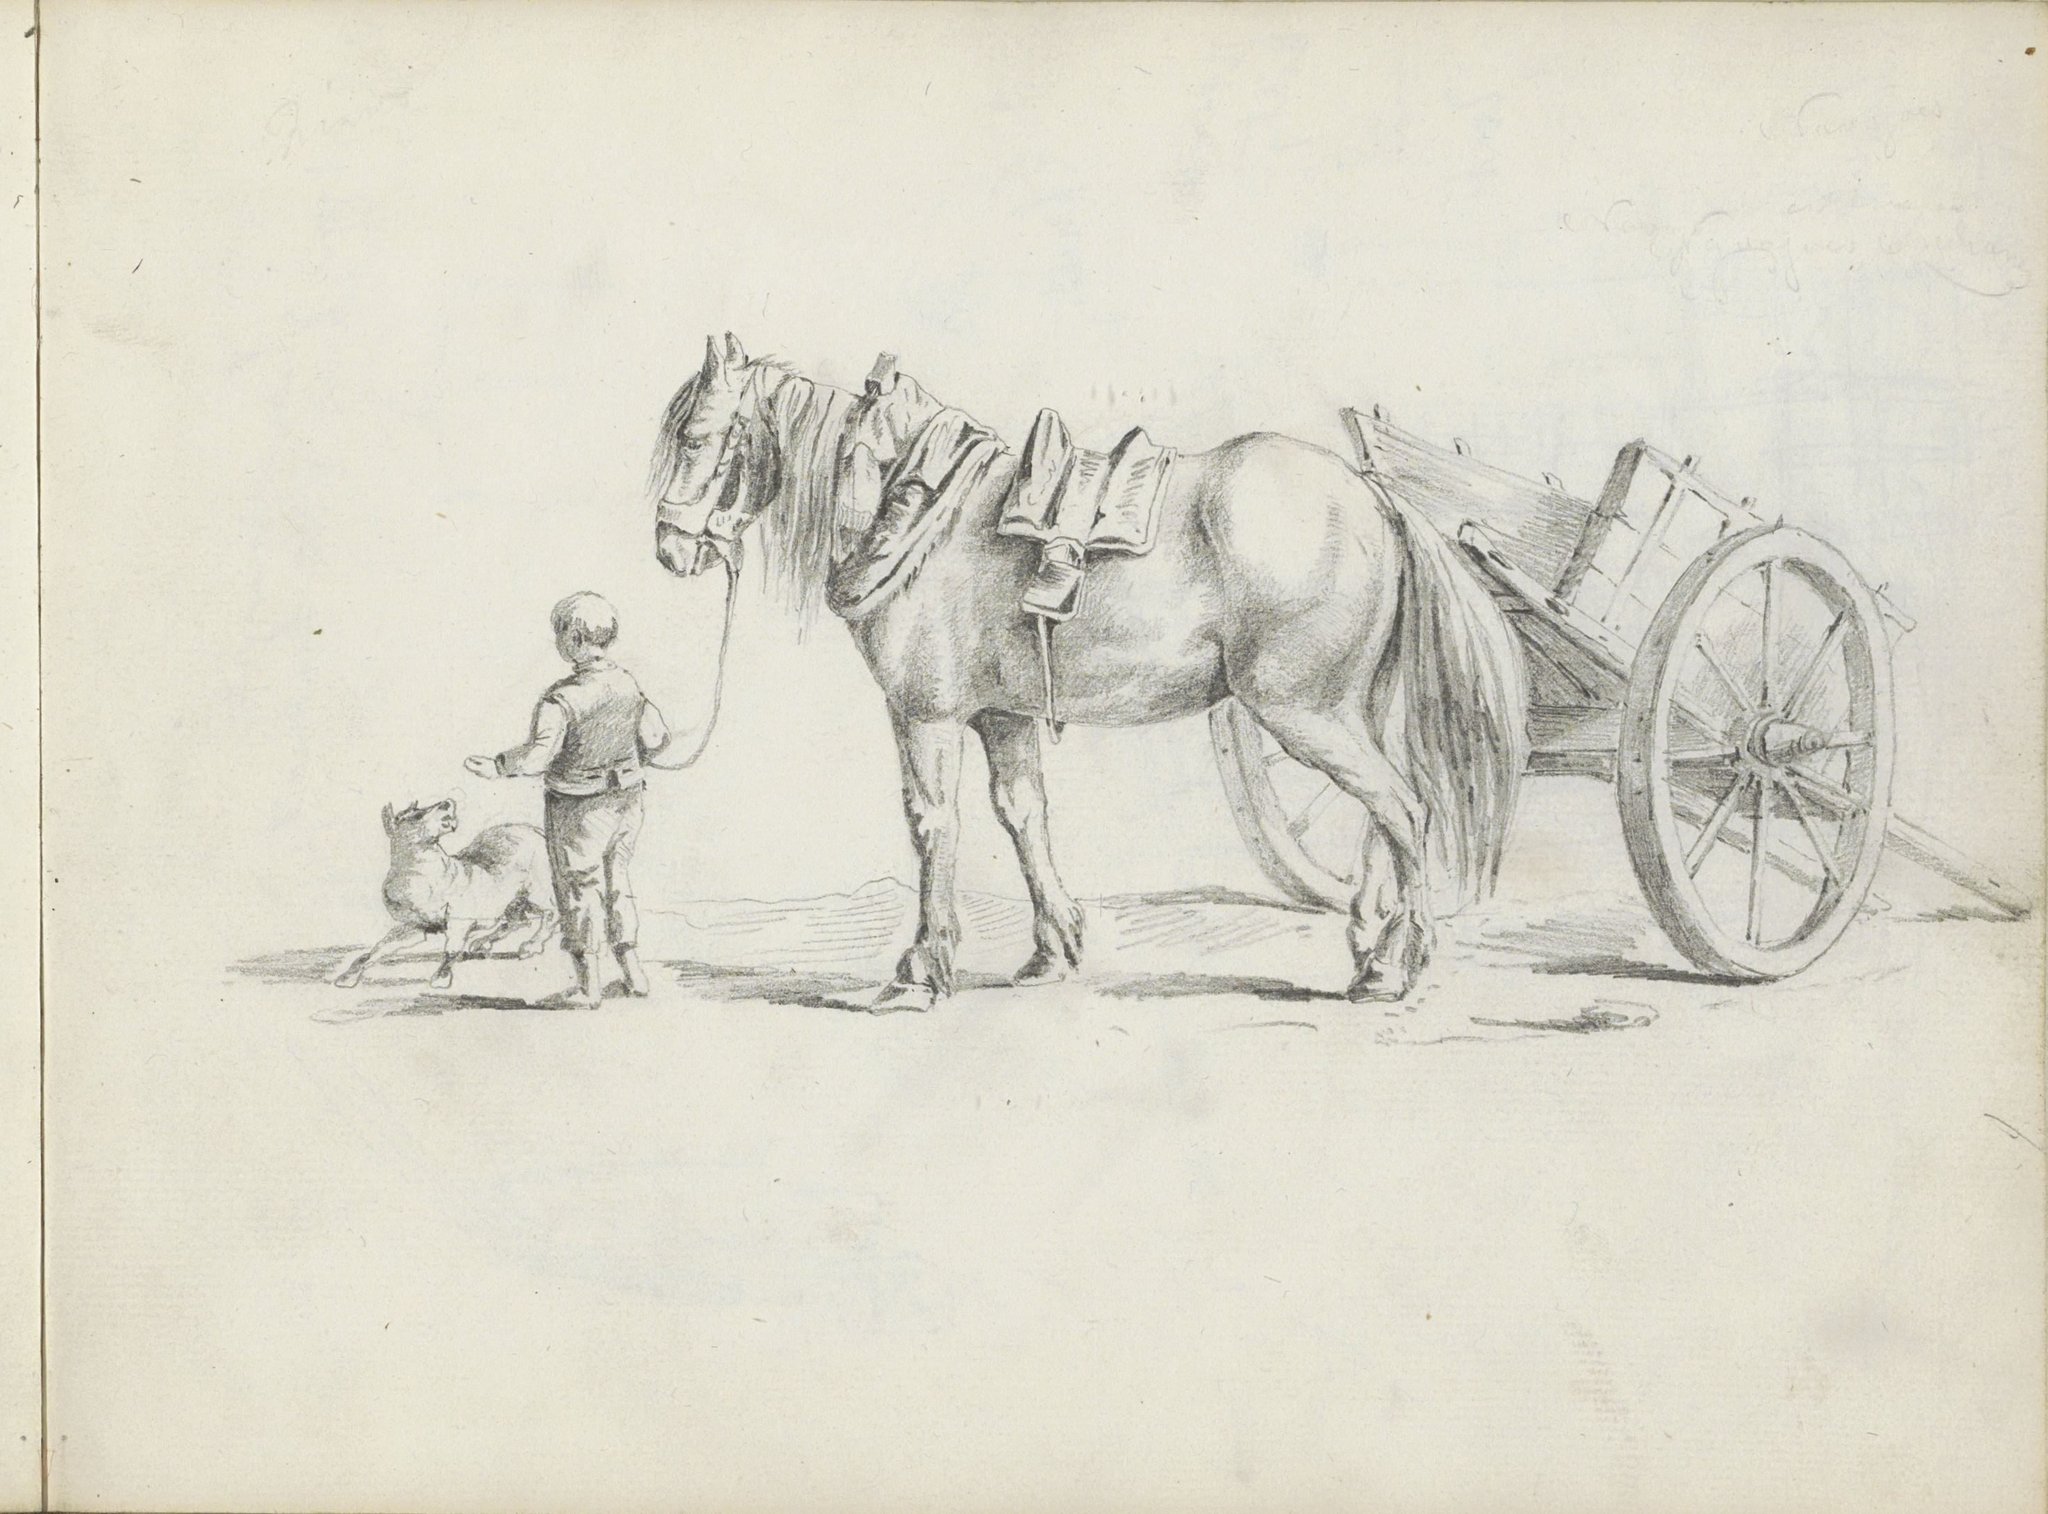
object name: sketchbook leaf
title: Jongen die het tuig van een paard vasthoudt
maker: hermanus willem koekkoek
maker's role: draughtsman, painter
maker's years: 1867-1929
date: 1849-1895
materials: paper, pencil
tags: hand-cart, boy (child between toddler and youth), horse, dog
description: Achter het paard staat een handkar. De jongen heeft een hond bij zich. Pagina 19 recto uit een schetsboek met 26 bladen.